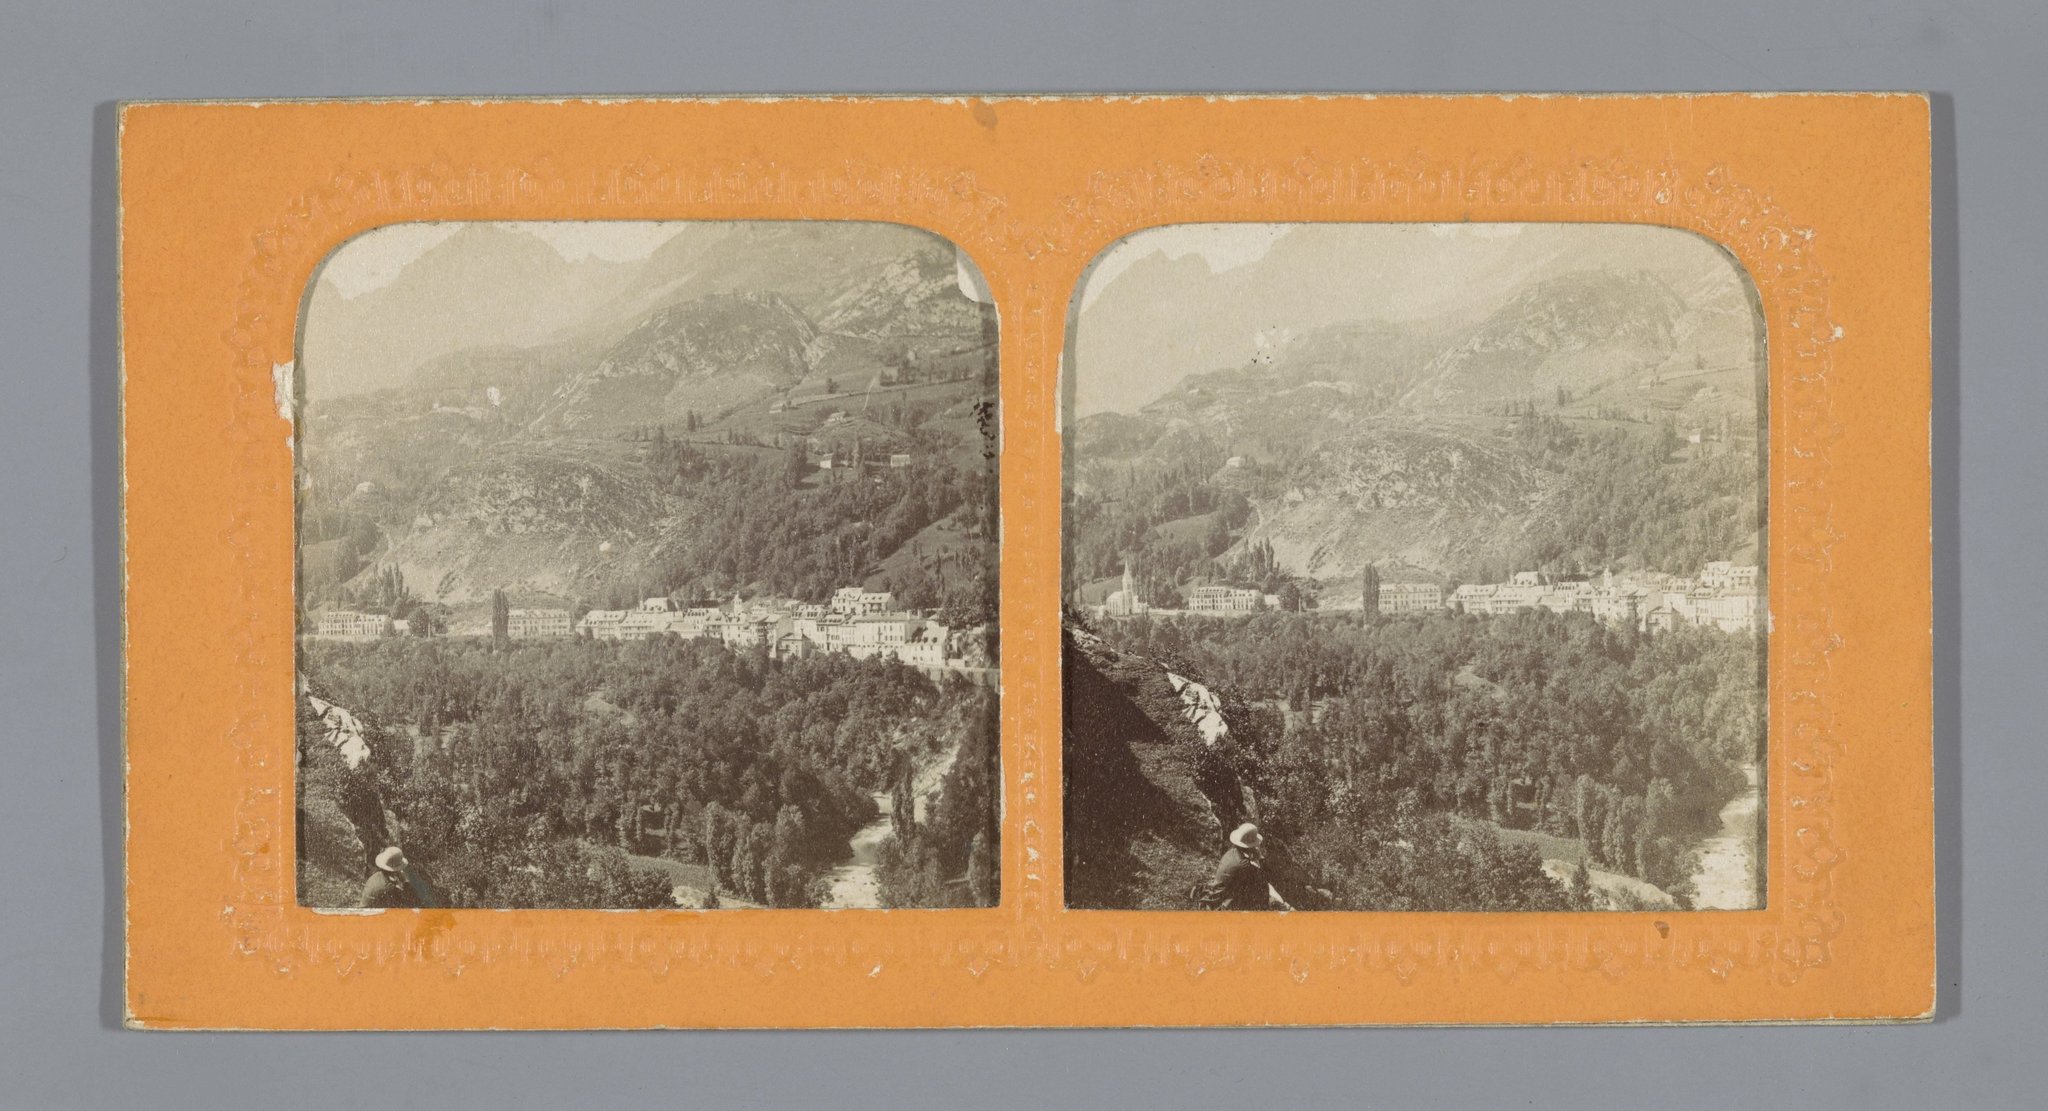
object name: tissue stereograph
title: Gezicht op Luz-Saint-Sauveur in de Franse Pyreneeën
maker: Anonymous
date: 1855-1875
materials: cardboard, paper, photographic support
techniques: albumen print, hand coloring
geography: luz-saint-sauveur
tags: prospect of village, silhouette of village, dale, valley (+ landscape with figures, staffage)